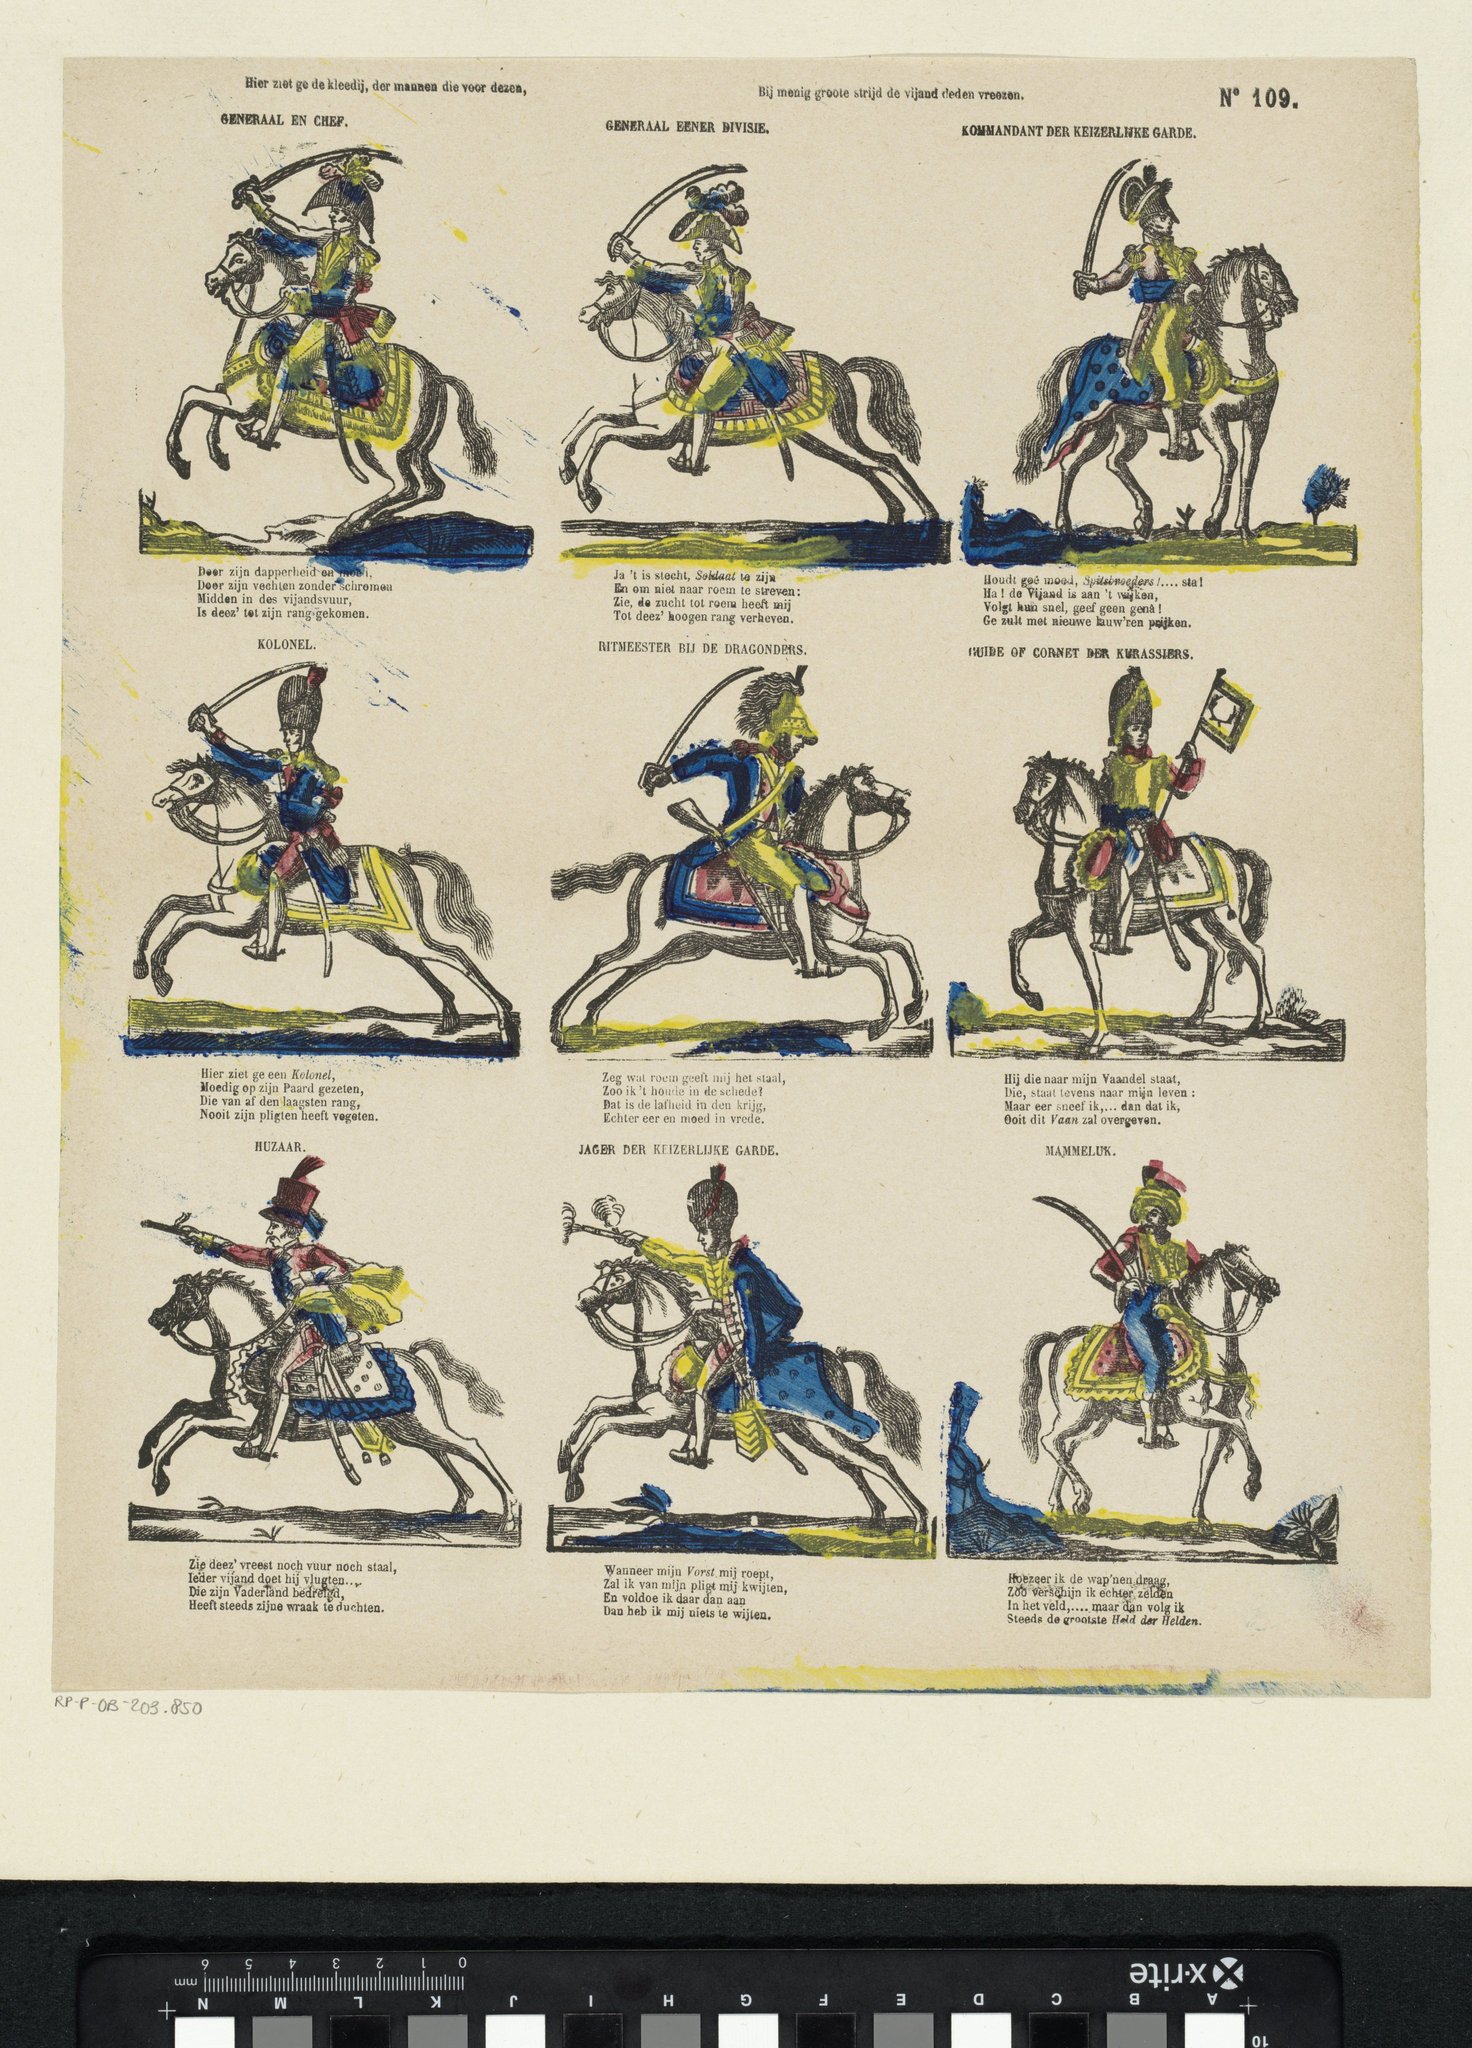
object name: popular print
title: Hier ziet ge de kleedij, der mannen die voor dezen, bij menig groote strijd de vijand deden vreezen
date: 1827-1894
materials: paper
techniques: colour, letterpress printing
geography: schaarbeek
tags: warfare; military affairs (+ cavalry, horsemen), the soldier; the soldier's life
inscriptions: collector's mark: Lugt 2760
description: Blad met 9 voorstellingen van militairen te paard. Onder elke afbeelding een vierregelig vers, boven elke afbeelding een titel. Genummerd rechtsboven: No. 109.